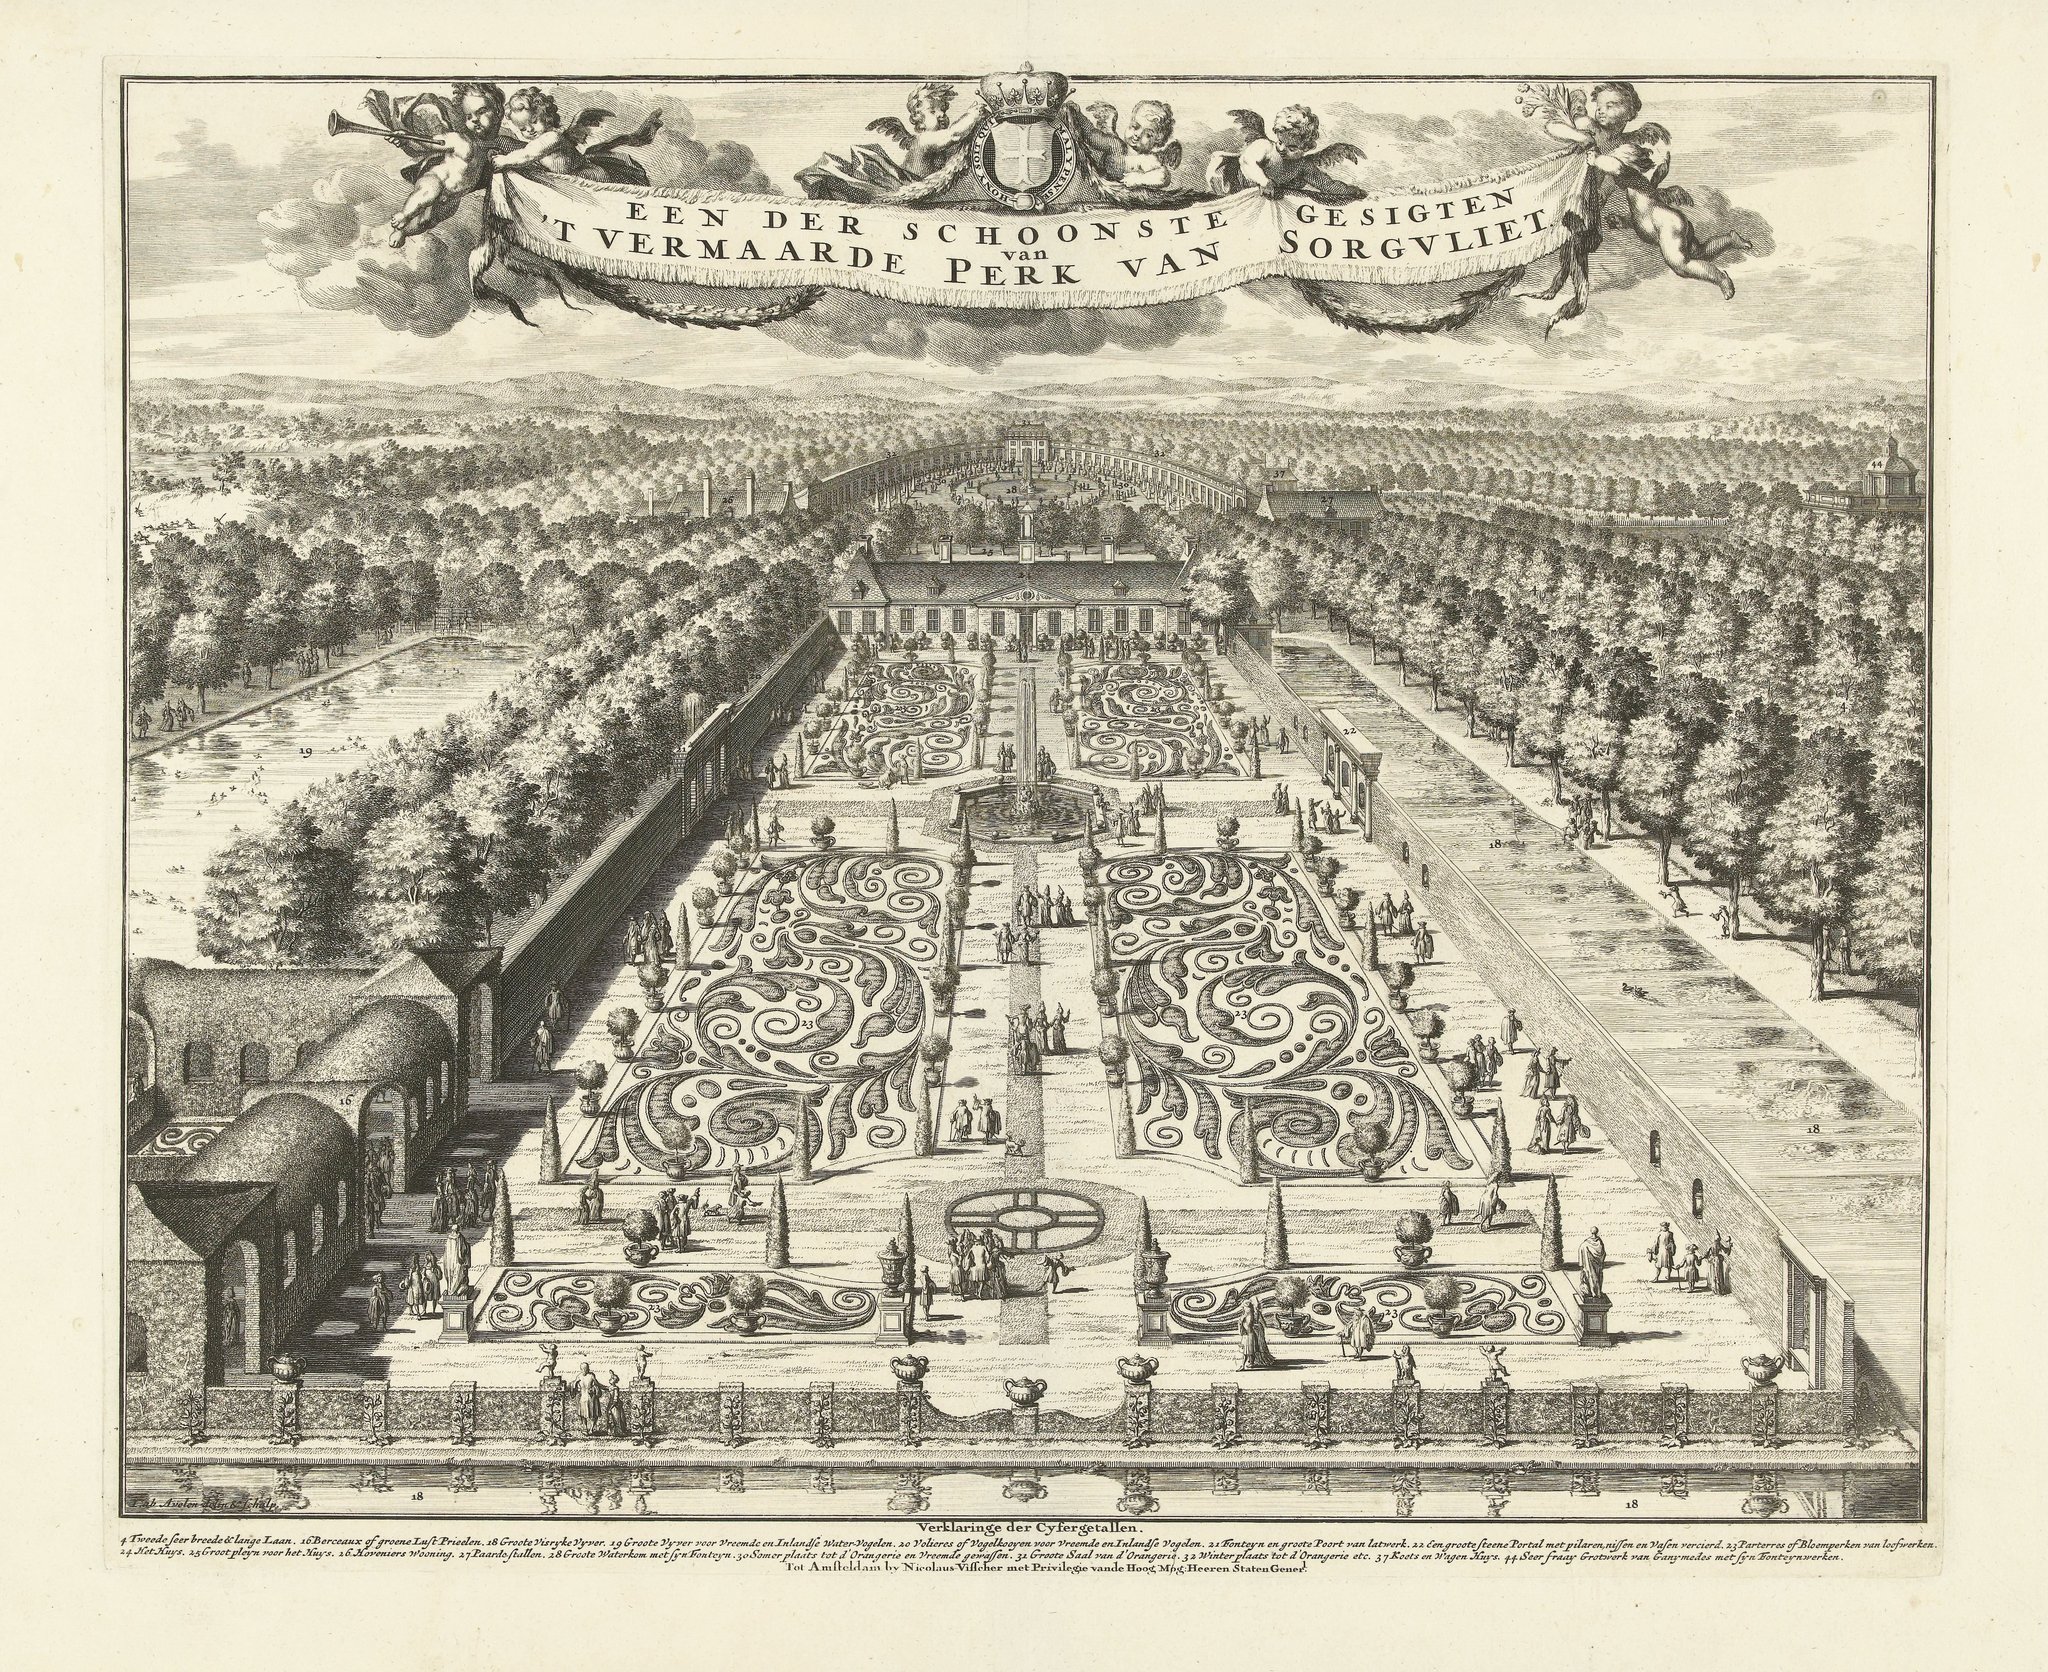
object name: print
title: Een der schoonste gesigten van 't vermaarde perk van Sorgvliet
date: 1691-1698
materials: paper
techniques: etching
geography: northern netherlands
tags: french or architectonic garden; formal garden, greenhouse, orangery, the hague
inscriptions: collector's mark: Lugt 2228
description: Vogelvluchtaanzicht van de parterretuin op het landgoed Zorgvliet, Den Haag. Op de middenas achtereenvolgens het Catshuis (24), een grote fontein (28) en de Oranjerie.